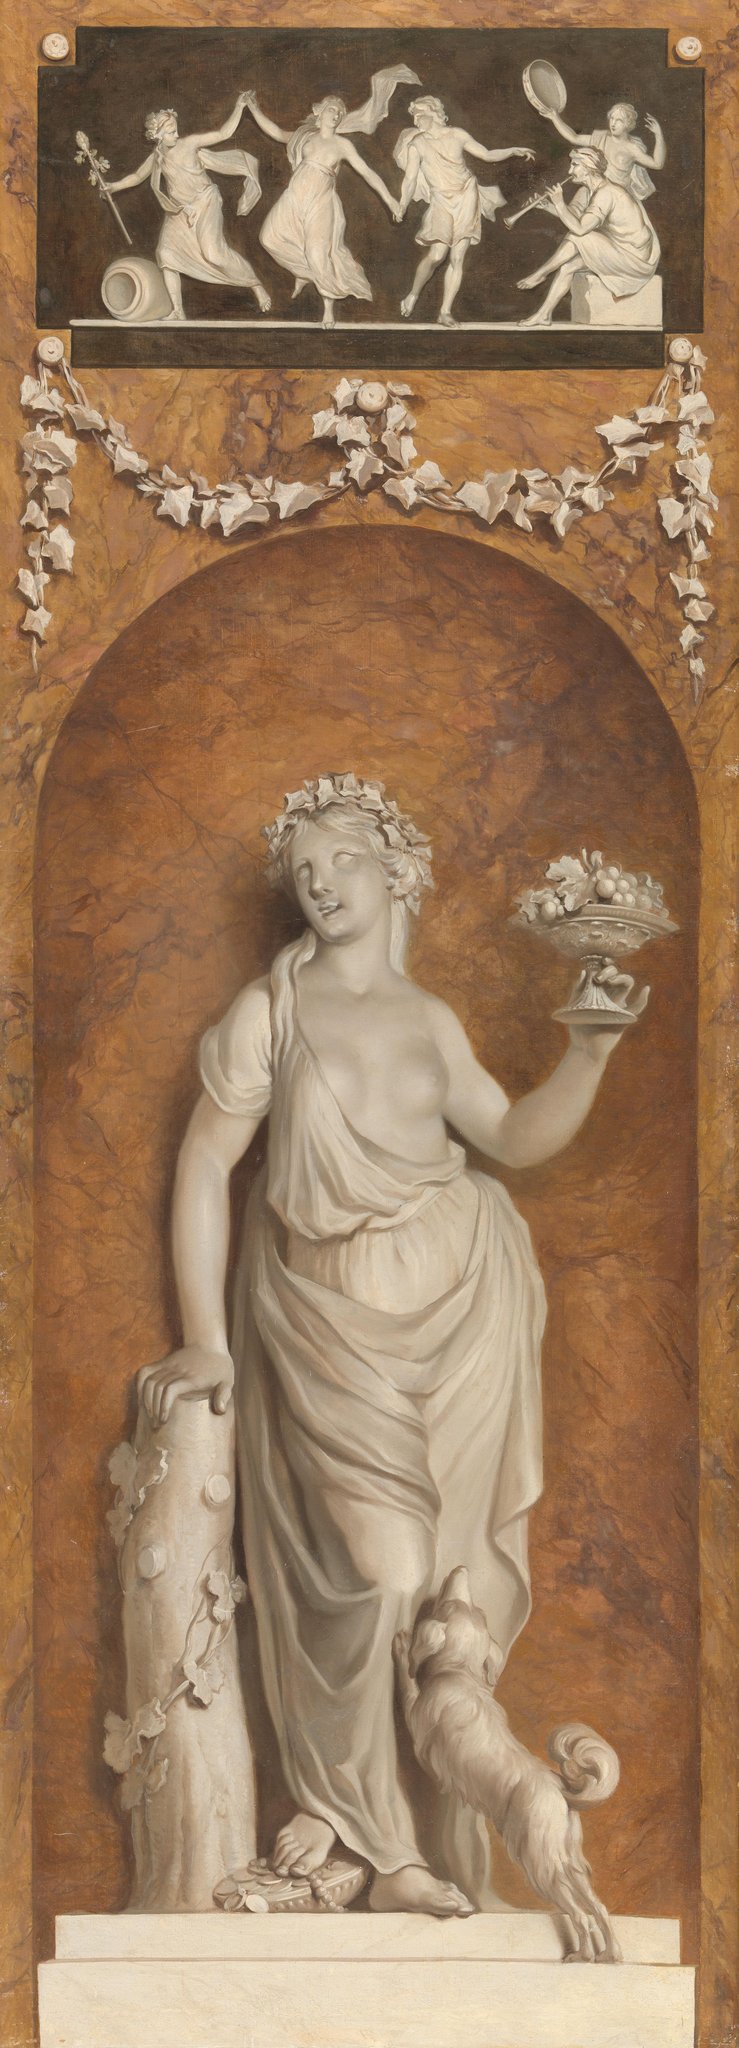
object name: painting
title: Behangselschildering met bacchante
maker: jurriaan andriessen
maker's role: draughtsman, painter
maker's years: 1742-1819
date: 1786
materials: canvas, oil, paint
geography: amsterdam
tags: maenad(s), female bacchant(es)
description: Trompe l'oeil: een witmarmeren sculptuur in een bruin gemarmerde nis. Boven de nissen zijn voorstellingen eveneens in trompe l'oeil weergegeven, in grisaille op zwart fond. Bacchante met een hond en een schaal met druiven, haar voet rust op een mand met munten. De bacchante rust tegen een boomstam. De nis is versierd met een klimoptak. Het fries stelt de musische kunsten voor: dans and muziek. Links ligt een amfoor op de grond.